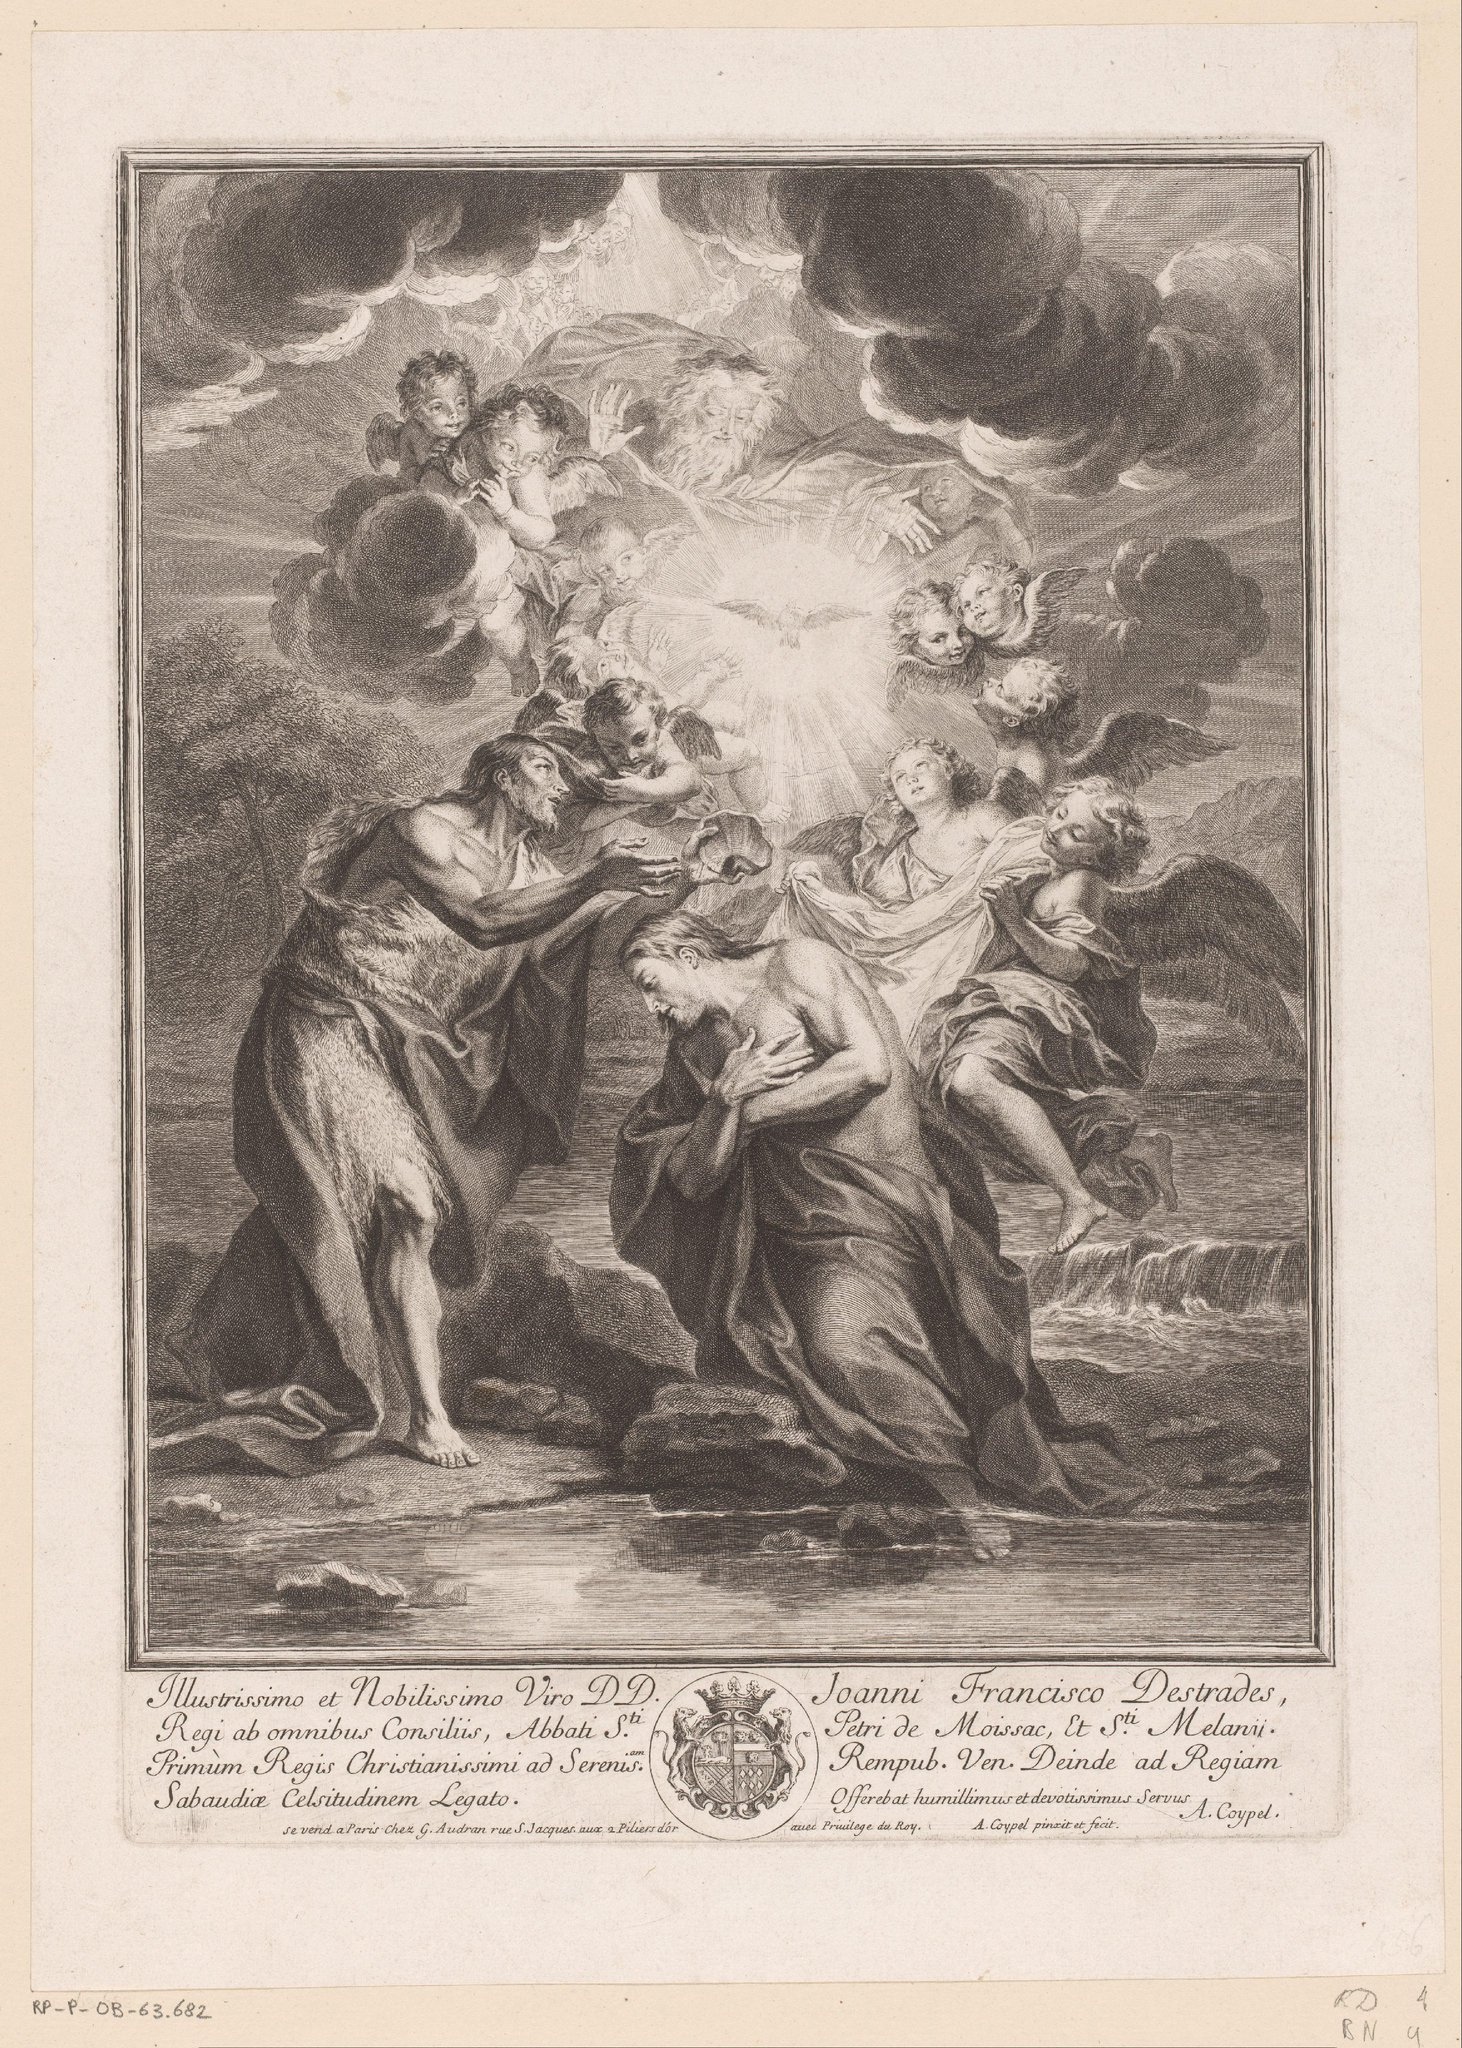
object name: print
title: Doop van Christus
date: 1671-1703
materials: paper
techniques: engraving, etching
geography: france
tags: baptism of christ in the river jordan: john the baptist pouring out water on christ's head: the holy ghost descends, armorial bearing, heraldry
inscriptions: collector's mark: Lugt 240